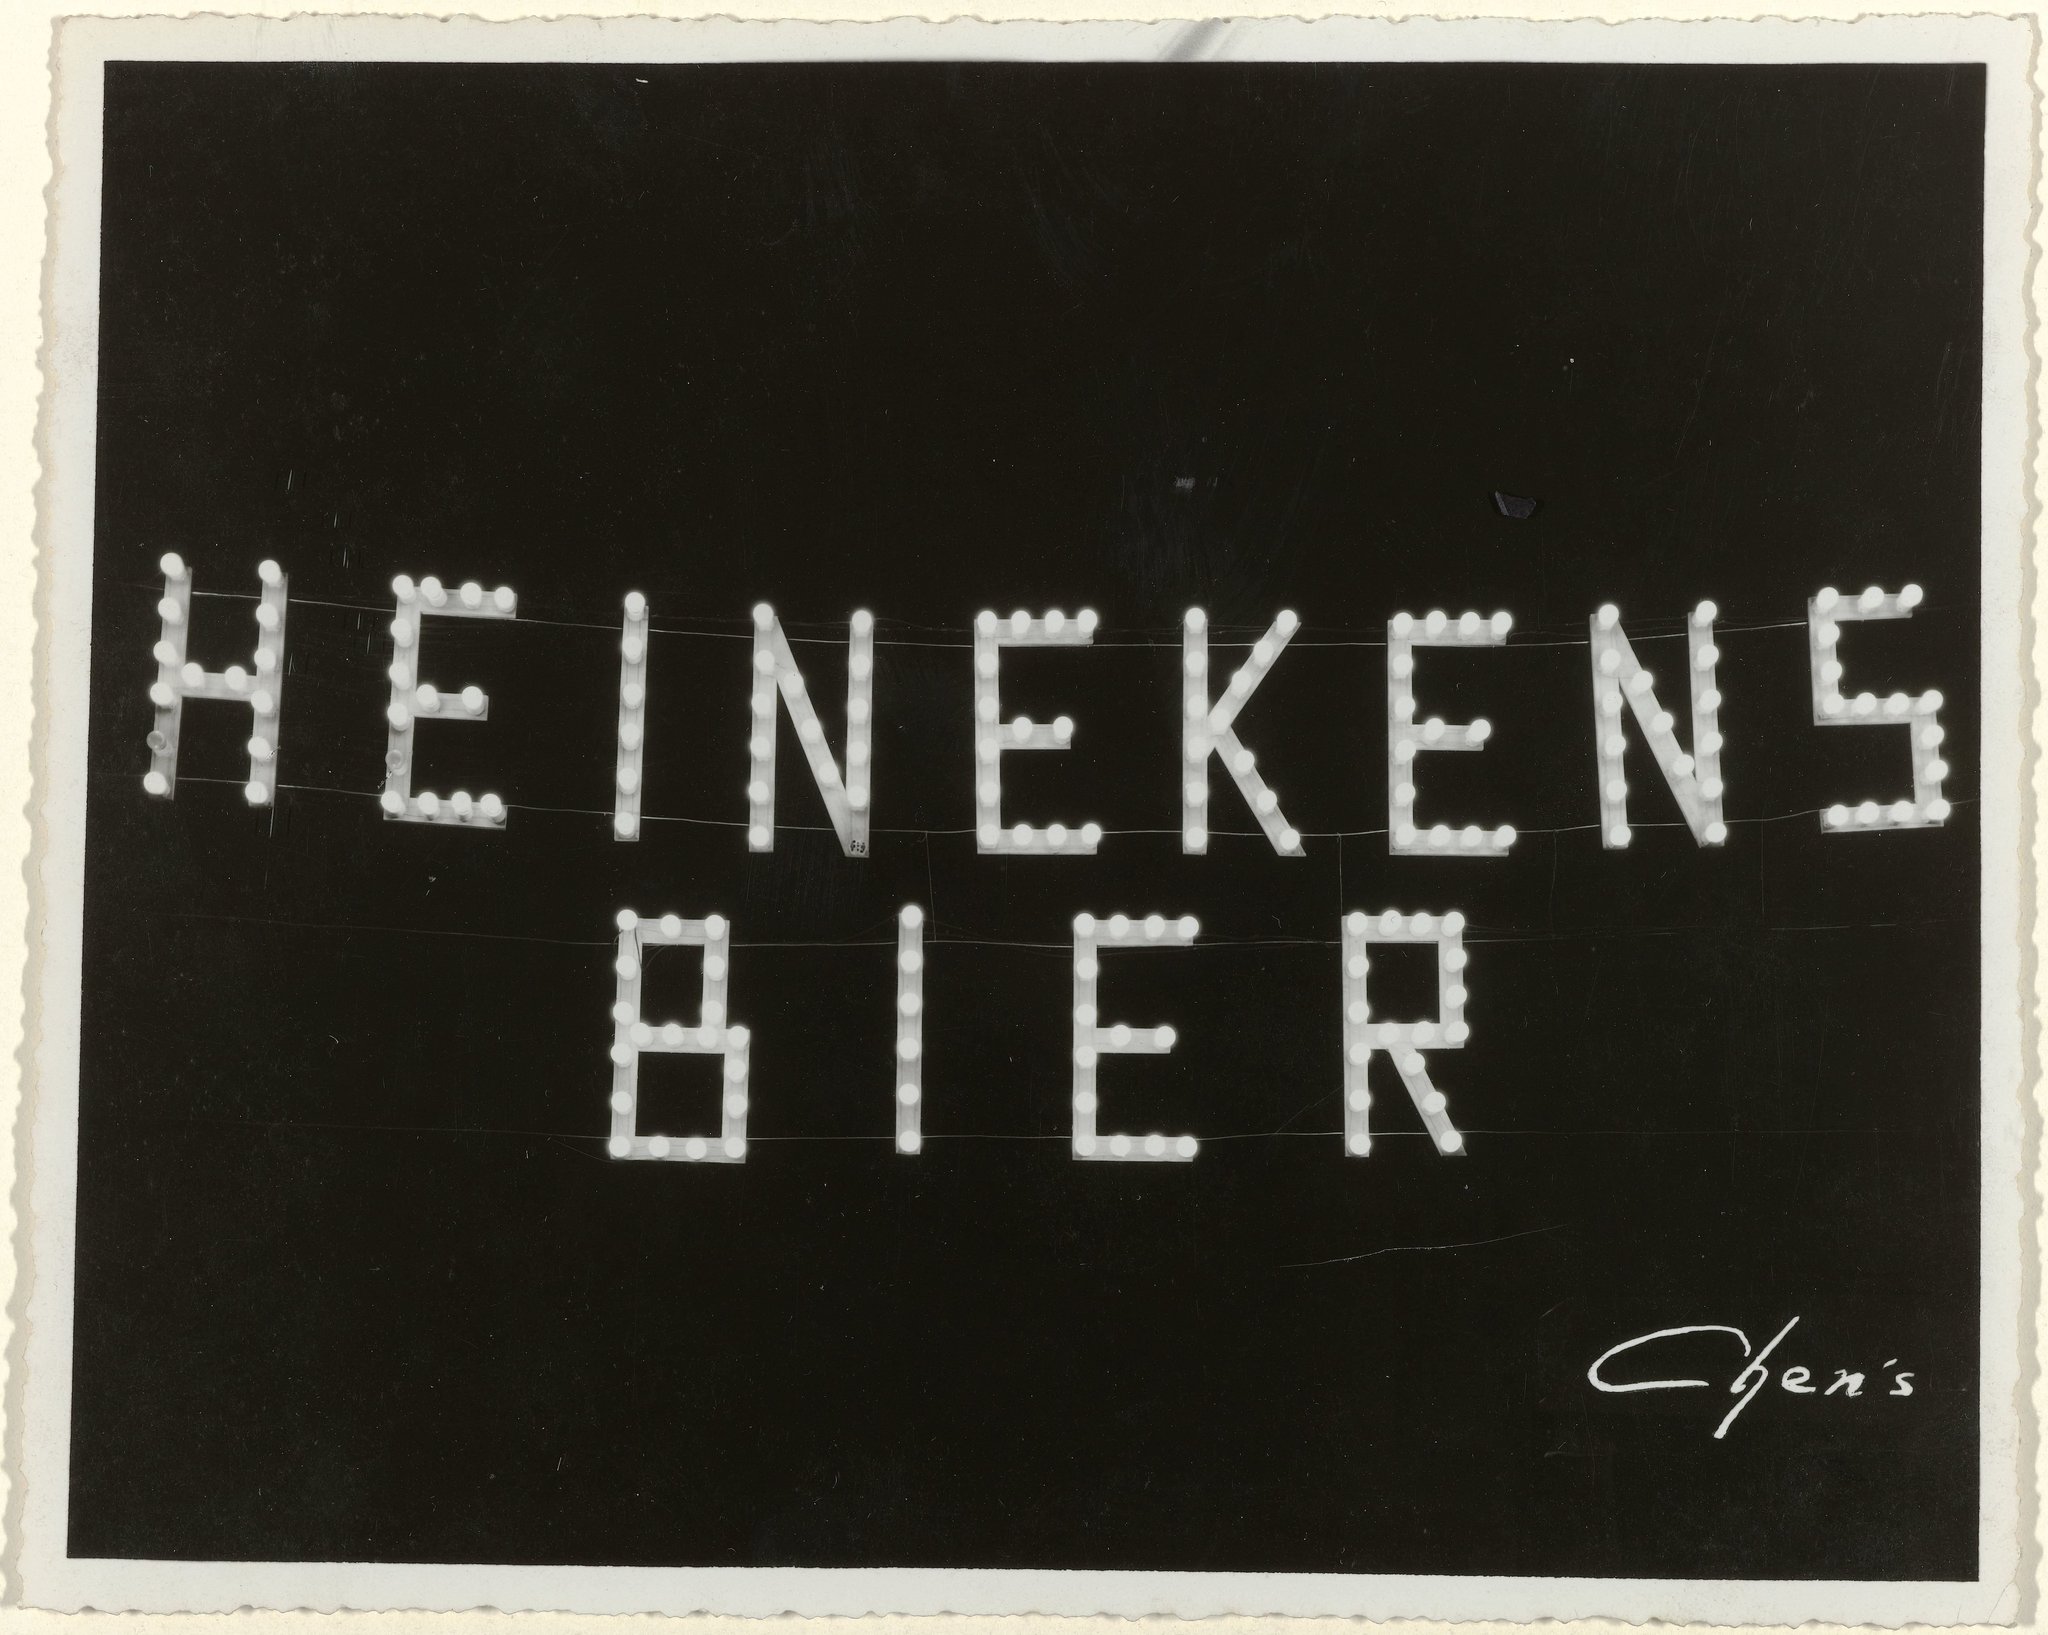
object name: photograph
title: Lichtreclame voor Heinekens Bier te Koetaradja feestelijk verlicht in 1937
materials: photographic support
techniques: gelatin silver print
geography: banda atjeh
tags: utrecht, bernhard (prins der nederlanden), the hague, juliana of the netherlands, dutch east indies, the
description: Lichtreclame voor Heinekens Bier naast de Atjeh Drukkerij te Koetaradja (Banda Atjeh) feestelijk verlicht, waarschijnlijk ter gelegenheid van het huwelijk van prinses Juliana en prins Bernhard op 7 januari 1937. Onderdeel van een groep van negen foto's over de Atjeh-drukkerij.